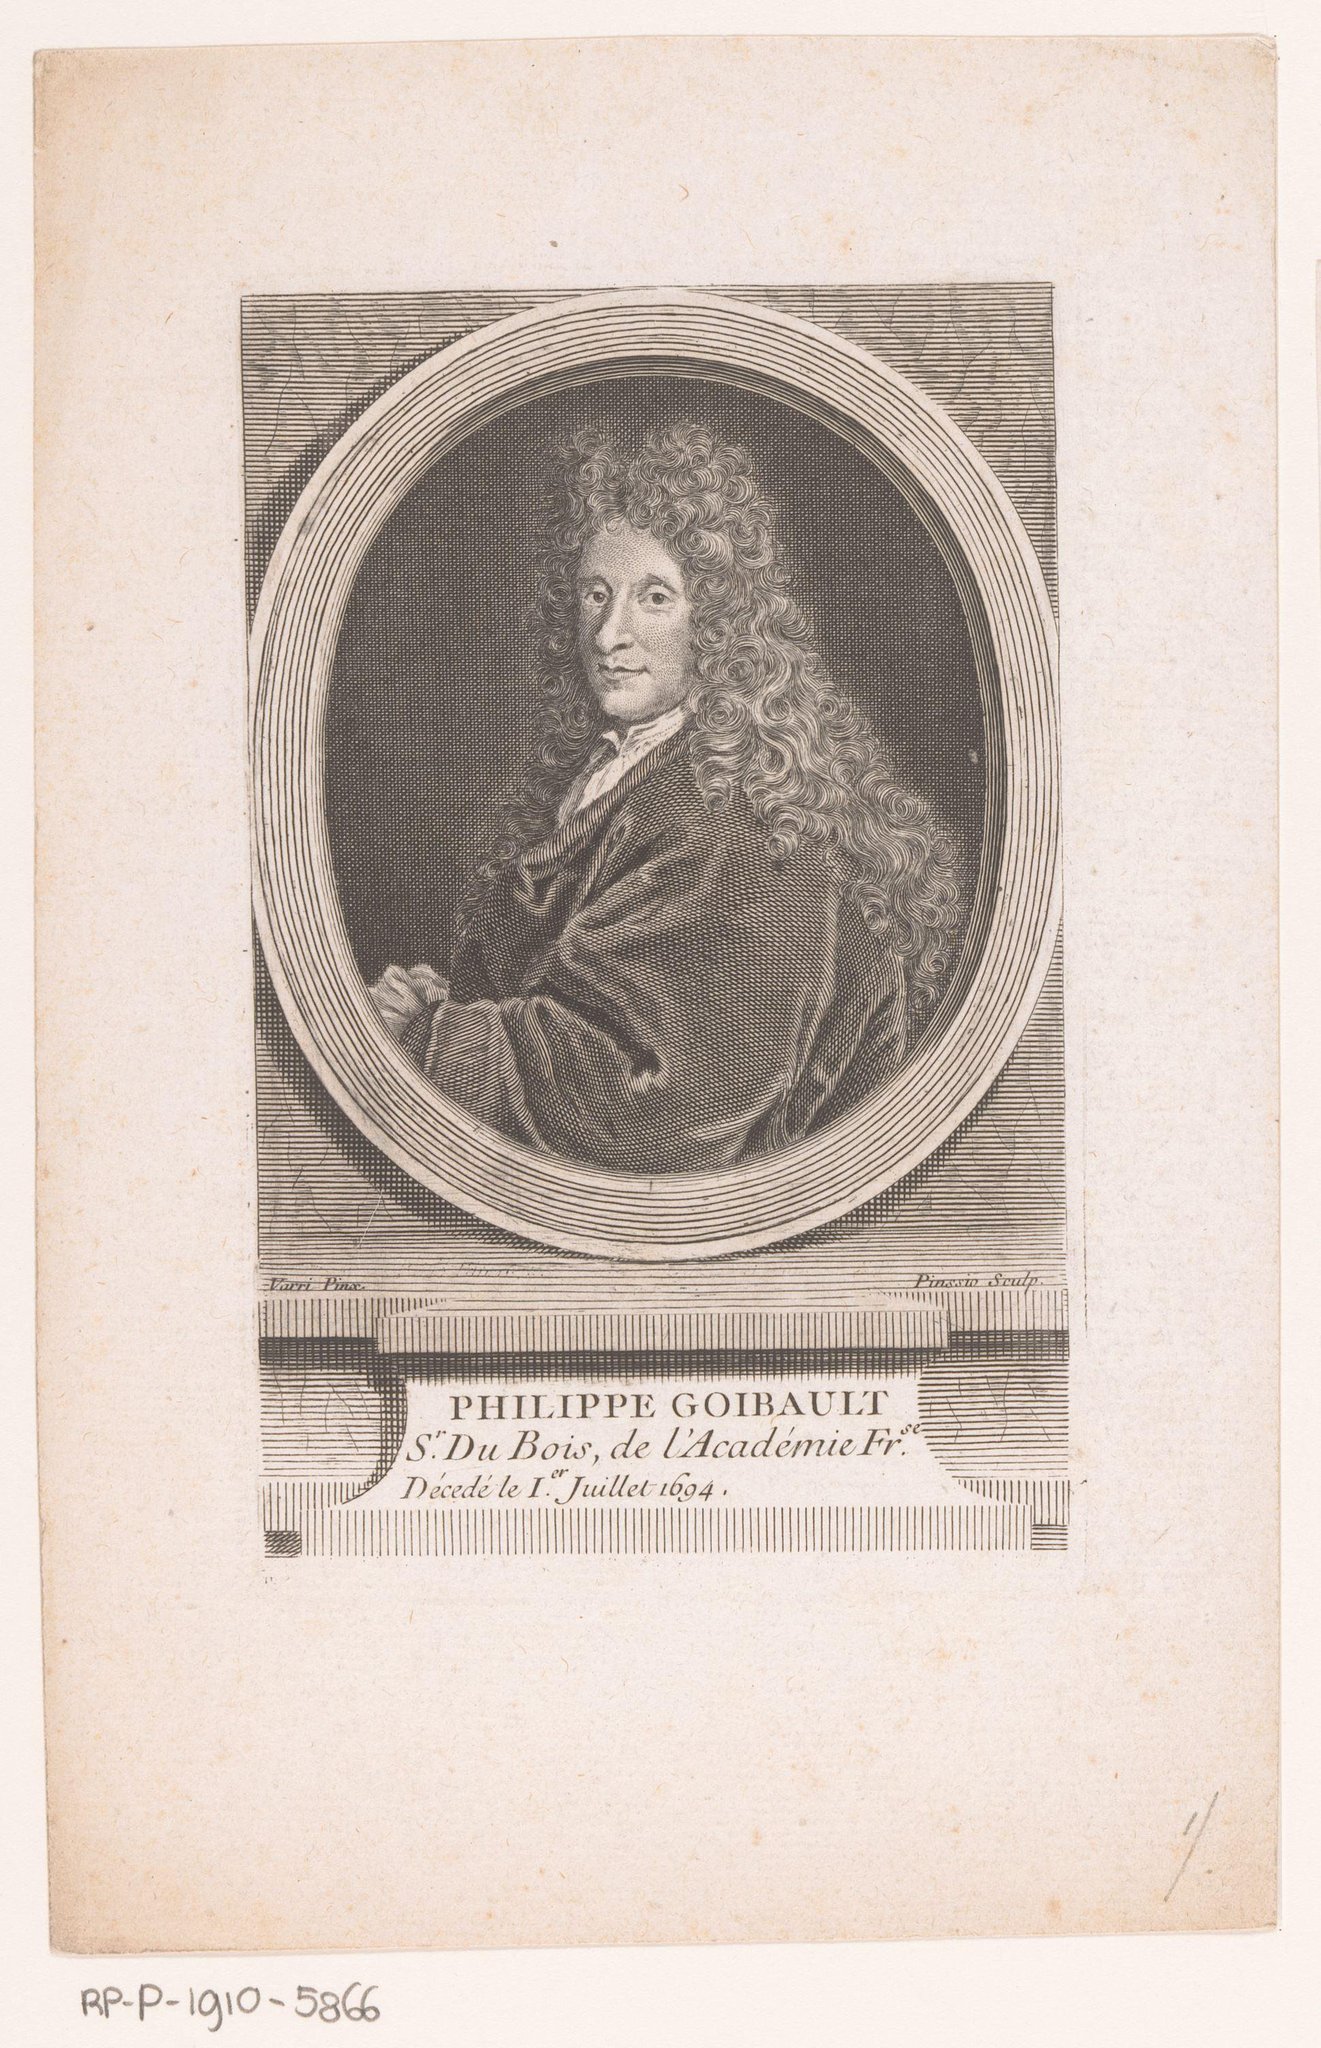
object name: print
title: Portret van Philippe Goibaut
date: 1755-1765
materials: paper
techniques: engraving, etching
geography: paris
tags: translator, historical persons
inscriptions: collector's mark: Lugt 2228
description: Prent uit: Dreux du Radier, Jean-François. L'Europe illustré, contenant l'histoire abregée des souverains, des princes, des prélats, des ministres, (...) en Europe: dans le XVe. siècle compris, jusqu'à présent. Parijs: Michel Odieuvre en André-François Le Breton, 1755-1765.